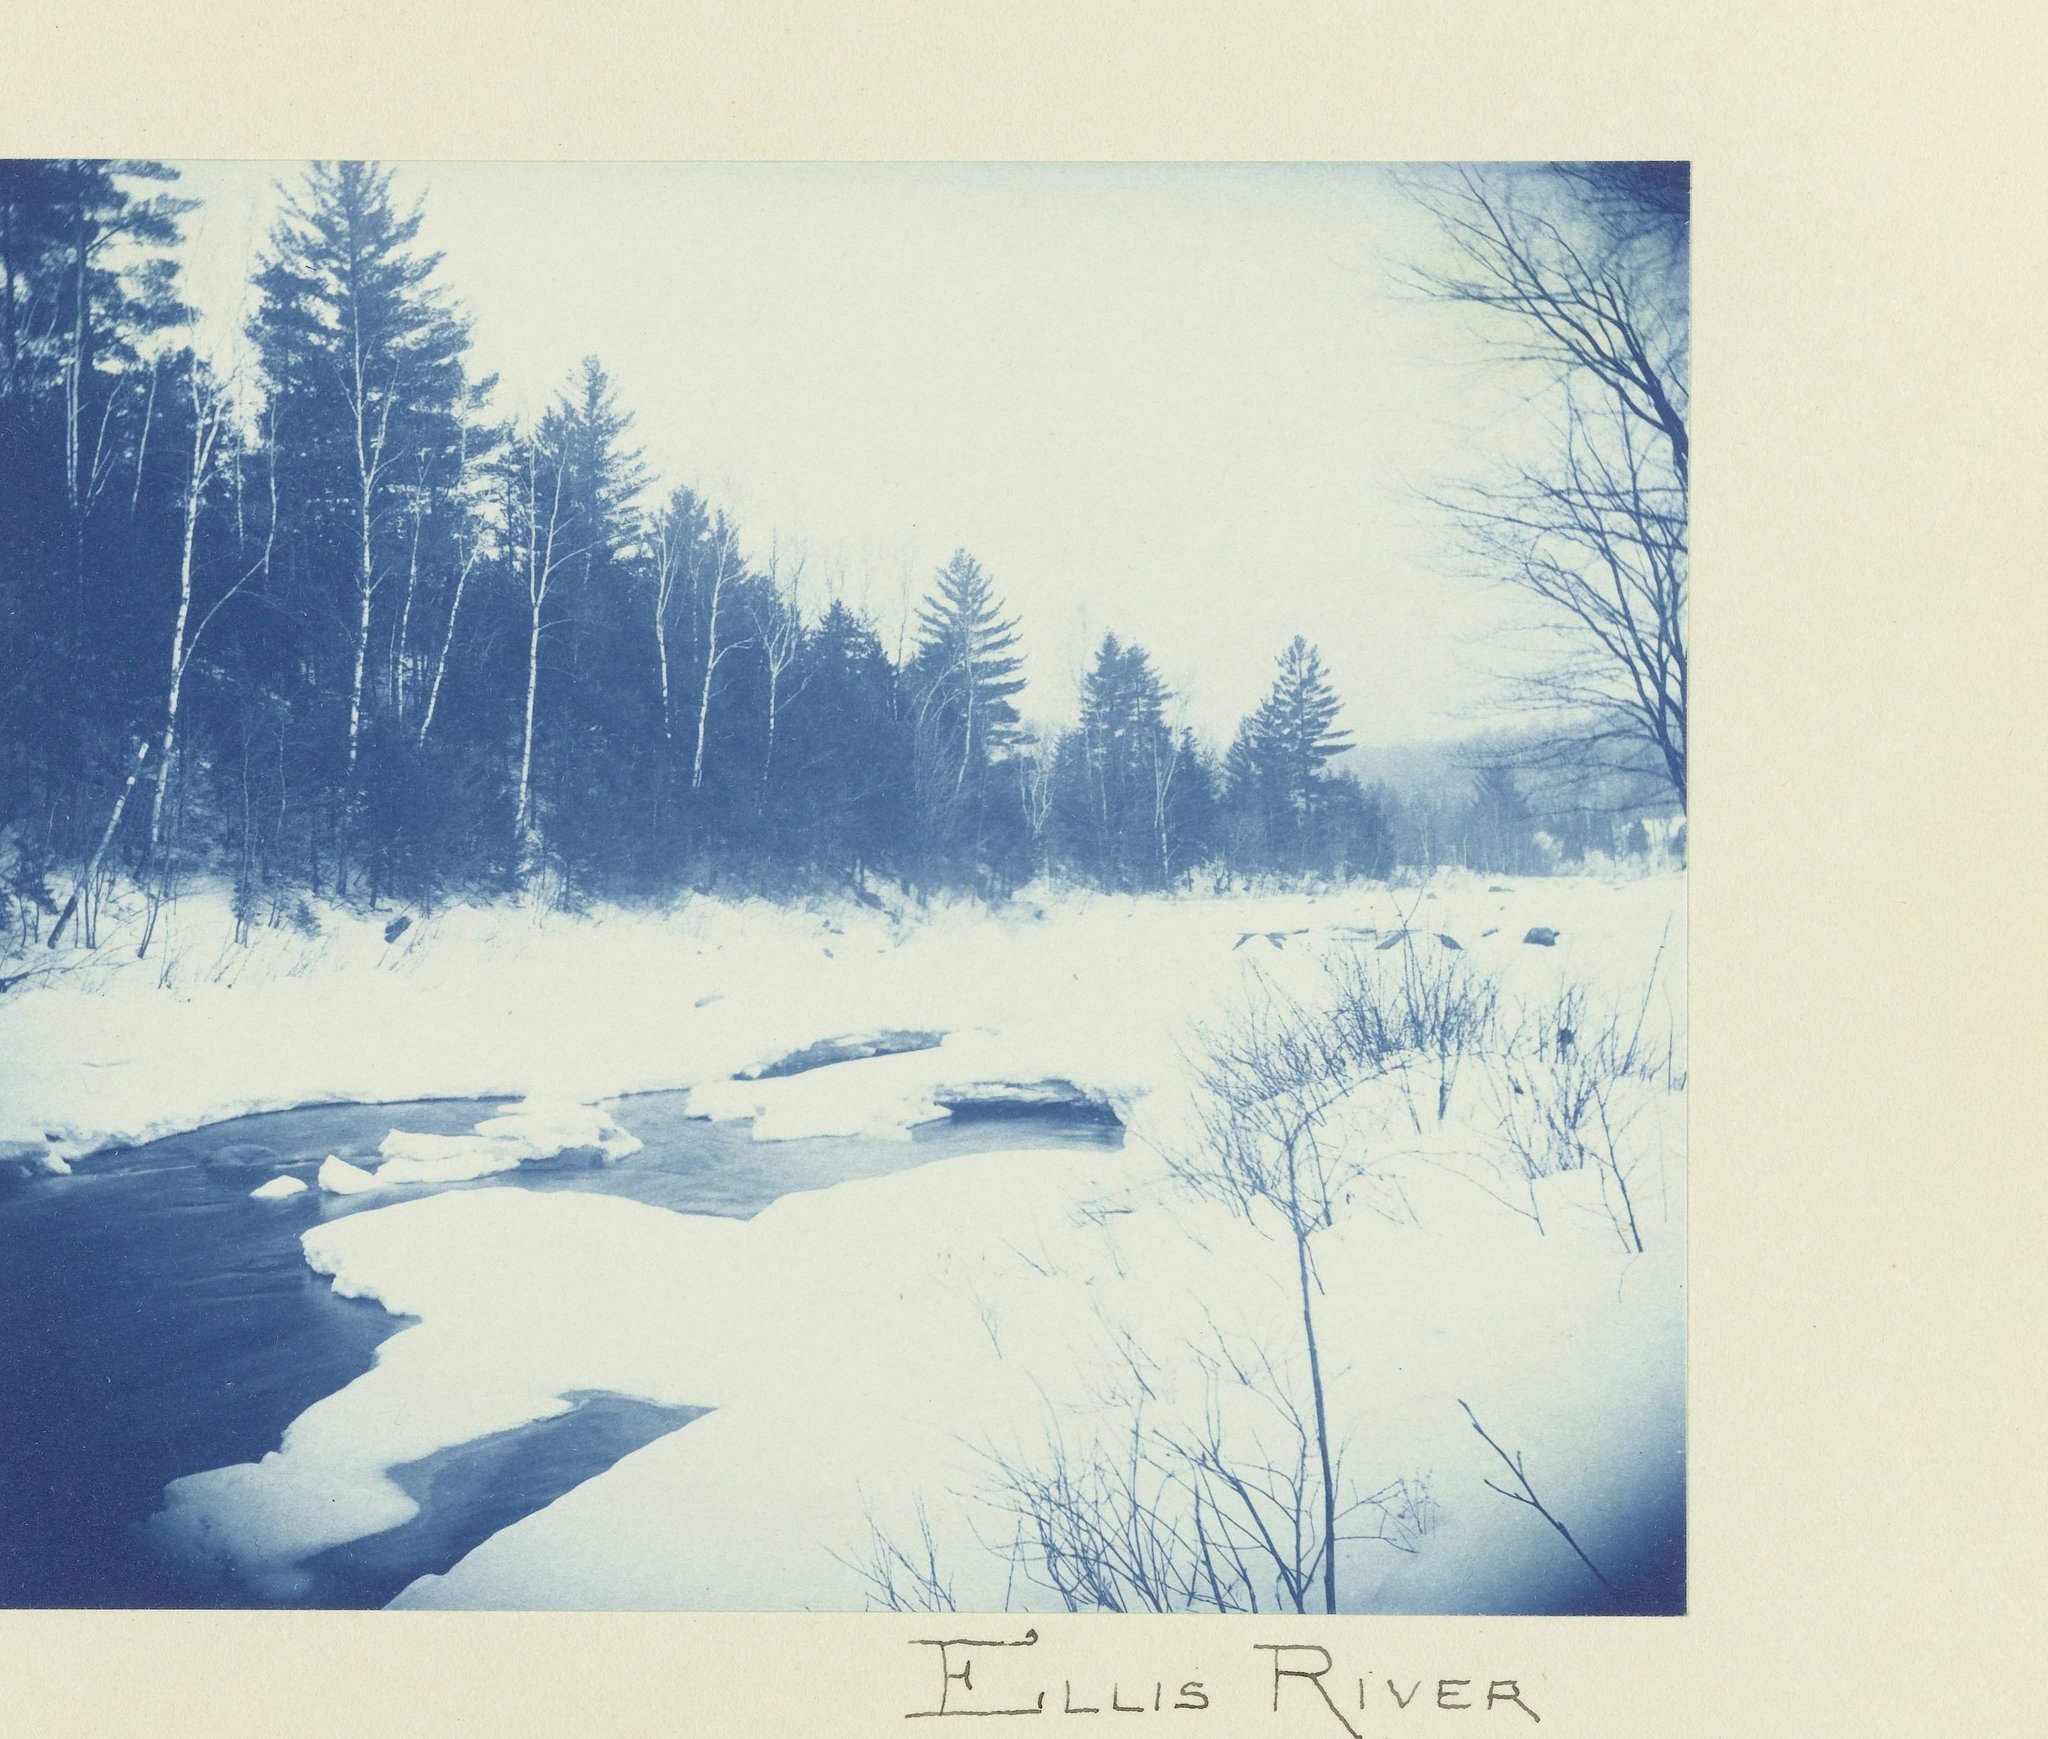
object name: photograph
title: Landschap in de sneeuw: Ellis River bij Iron Mountain House, NH, Verenigde Staten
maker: charlotte m. endicott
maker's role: fotograaf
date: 1899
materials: photographic support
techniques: cyanotype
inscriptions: title: ‘ELLIS RIVER / IN FRONT OF IRON MT. HOUSE./ FEB. 22. 1899.’